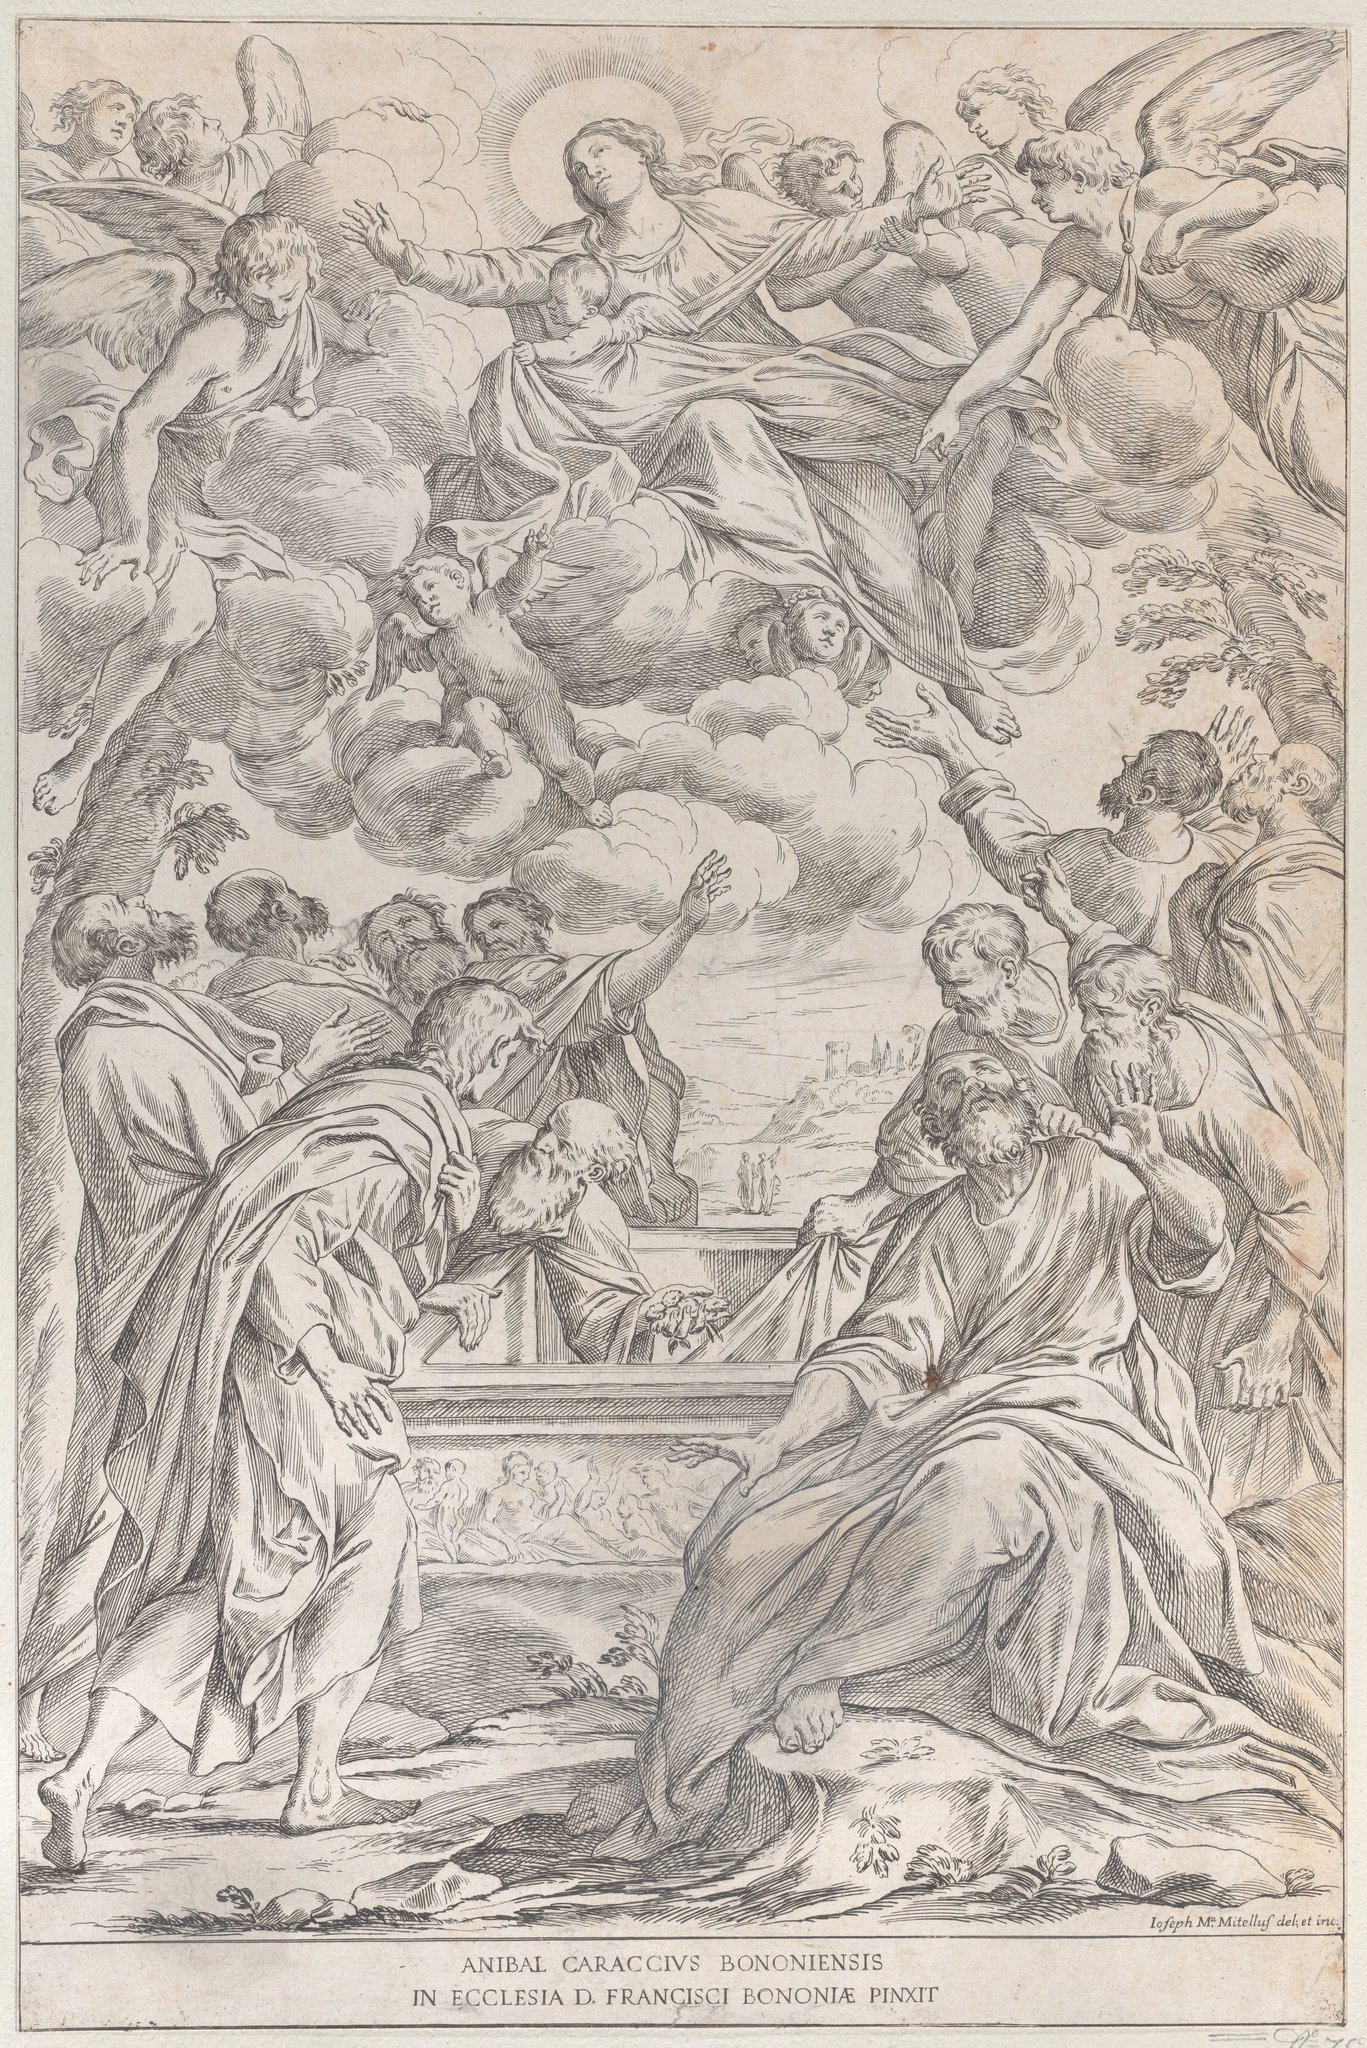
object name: print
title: The Assumption of the Virgin, plate 3 from "Bononiensium Pictorum Celebrioris..."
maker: giuseppe maria mitelli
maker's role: artist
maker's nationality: italian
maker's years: 1634-1718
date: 1678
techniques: etching